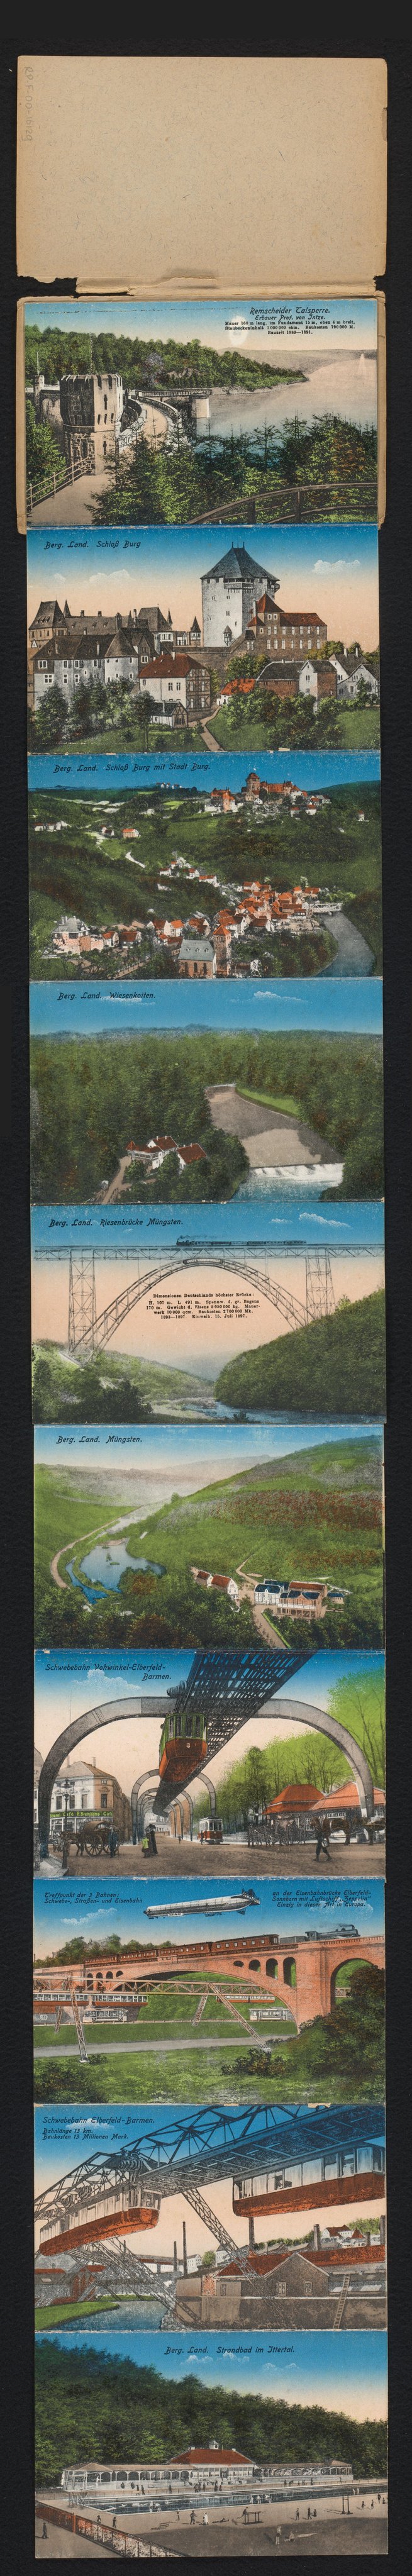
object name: accordion book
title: Das Bergische Land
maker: Anonymous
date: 1905-1930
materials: paper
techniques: lithograph, letterpress printing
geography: germany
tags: mountains, germany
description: Leporelloalbum met tien prentbriefkaarten.